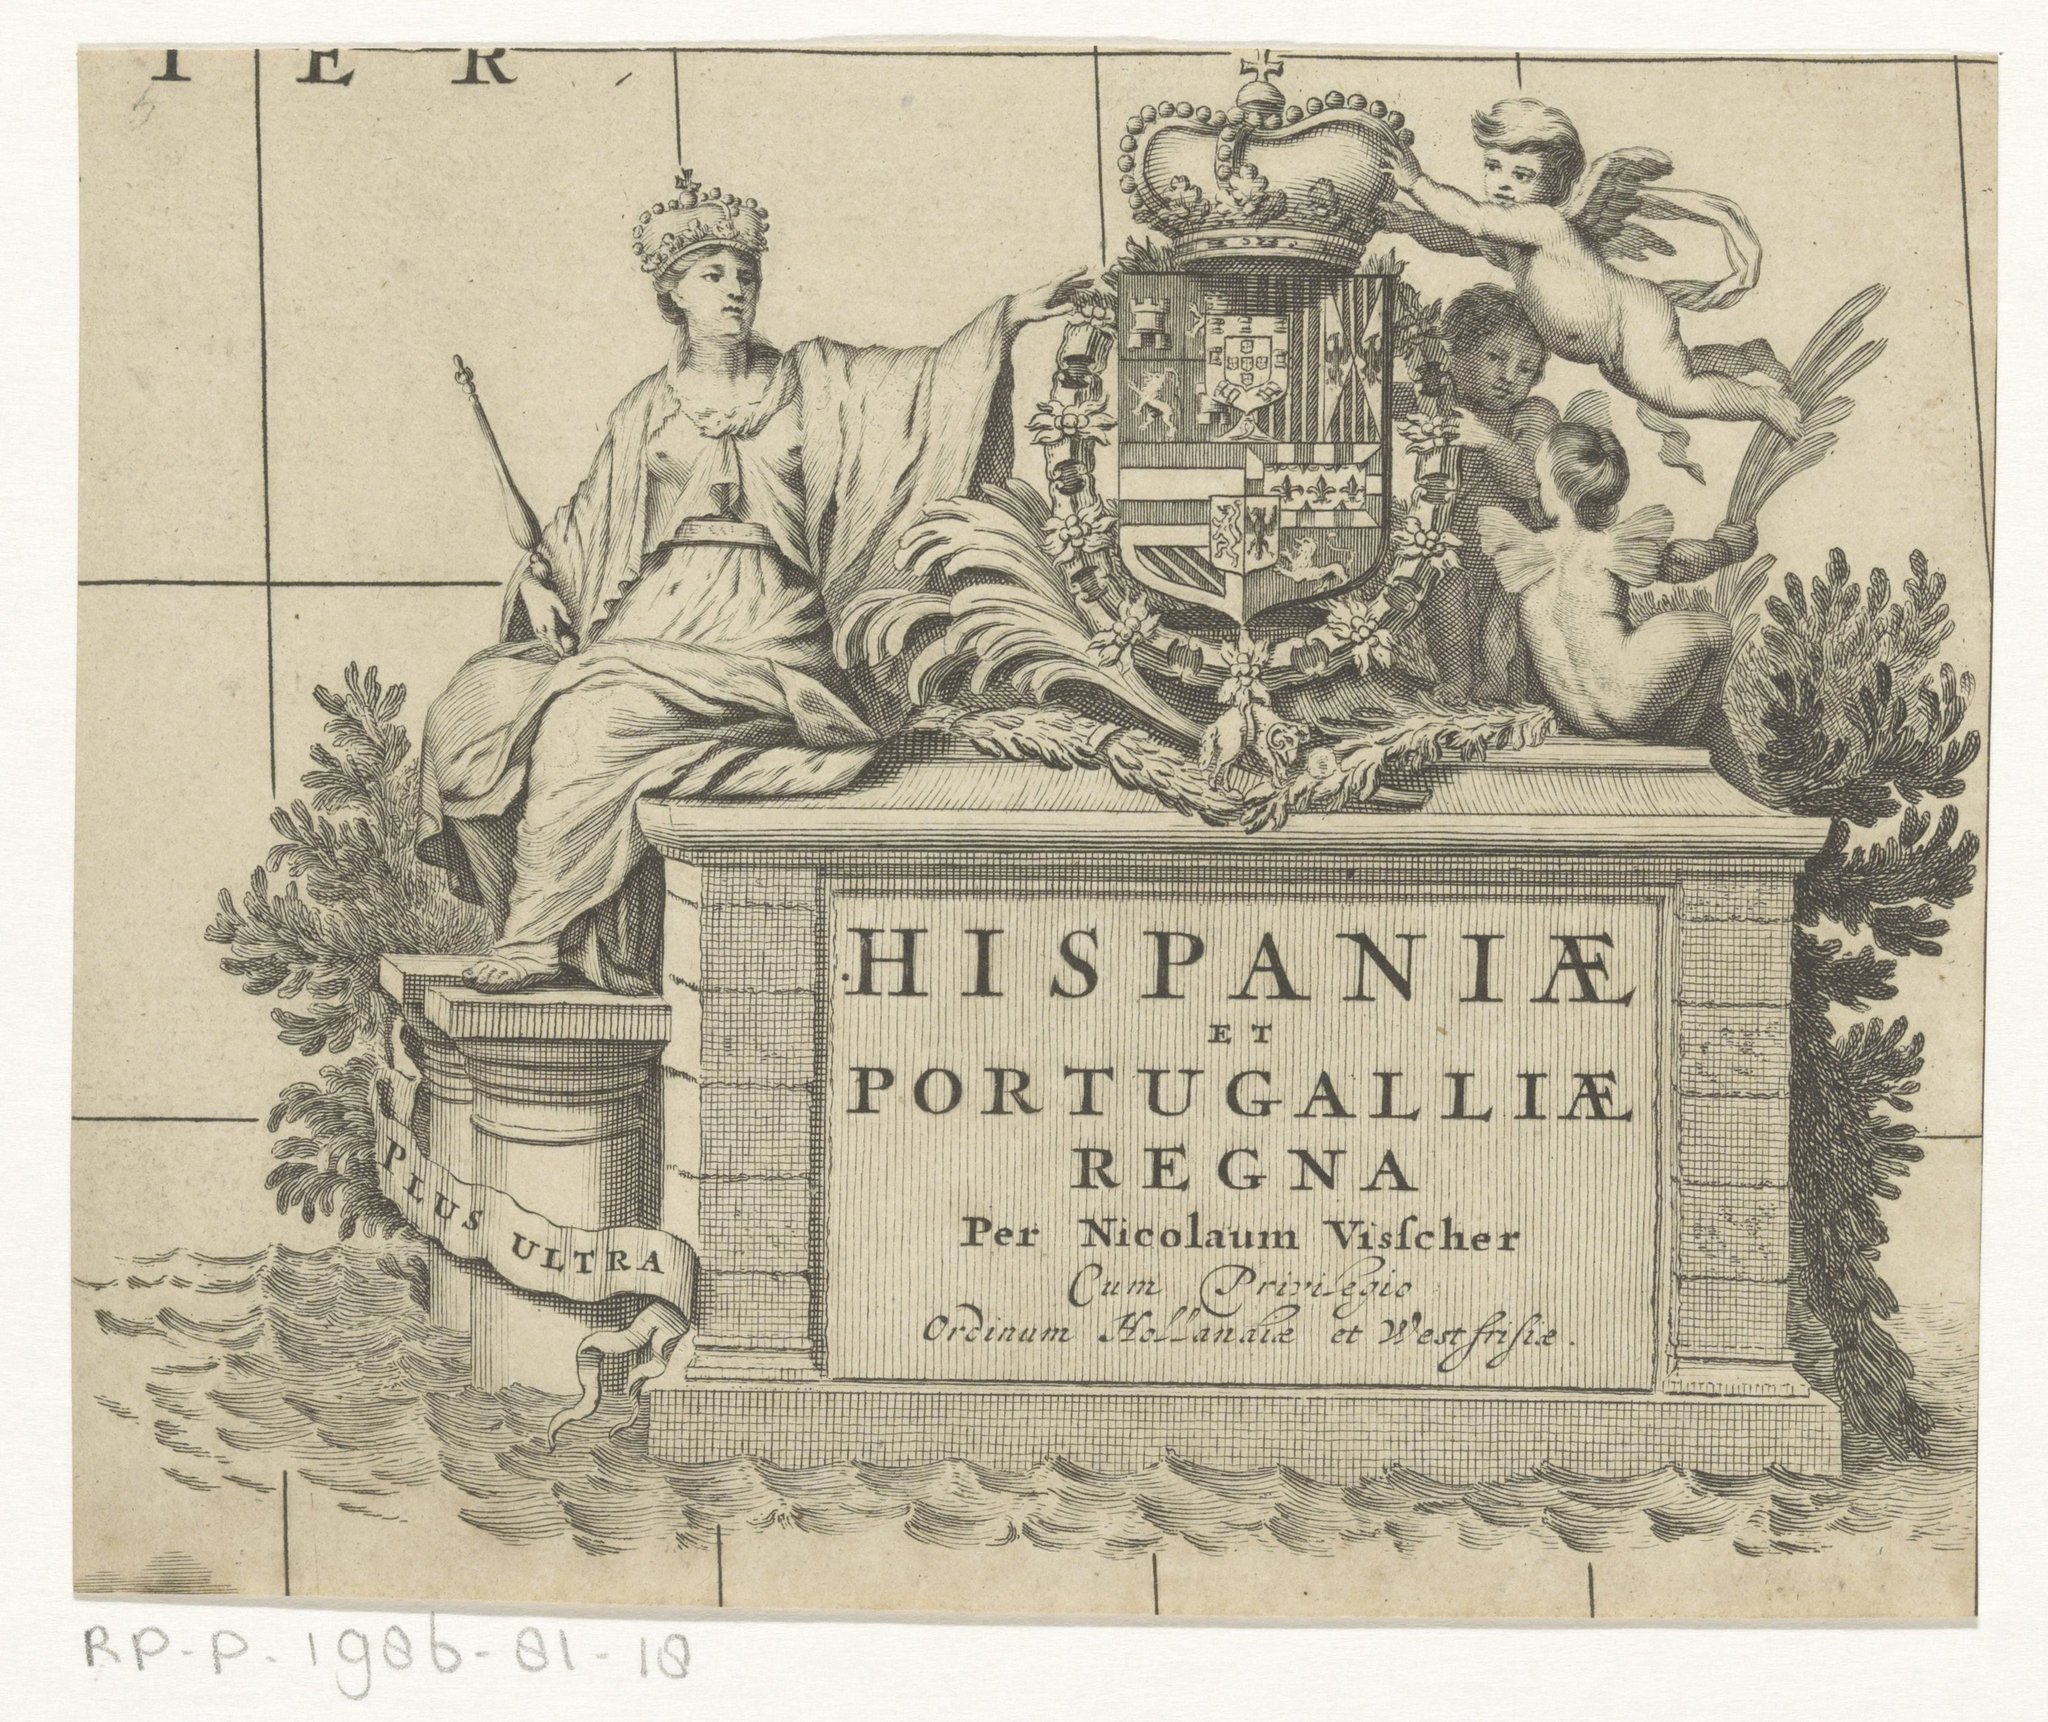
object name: print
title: Gekroonde vrouw naast het wapen van Spanje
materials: paper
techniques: engraving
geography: amsterdam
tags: coat of arms (as symbol of the state, etc.), sitting figure - aa - female human figure, spain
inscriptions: collector's mark: Lugt 2228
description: Een gekroonde vrouw met scepter zit op een muur met titel naast het gekroonde wapenschild van Spanje. Rechts drie putti met palmtak. Detail van een kaart van het Iberisch schiereiland.